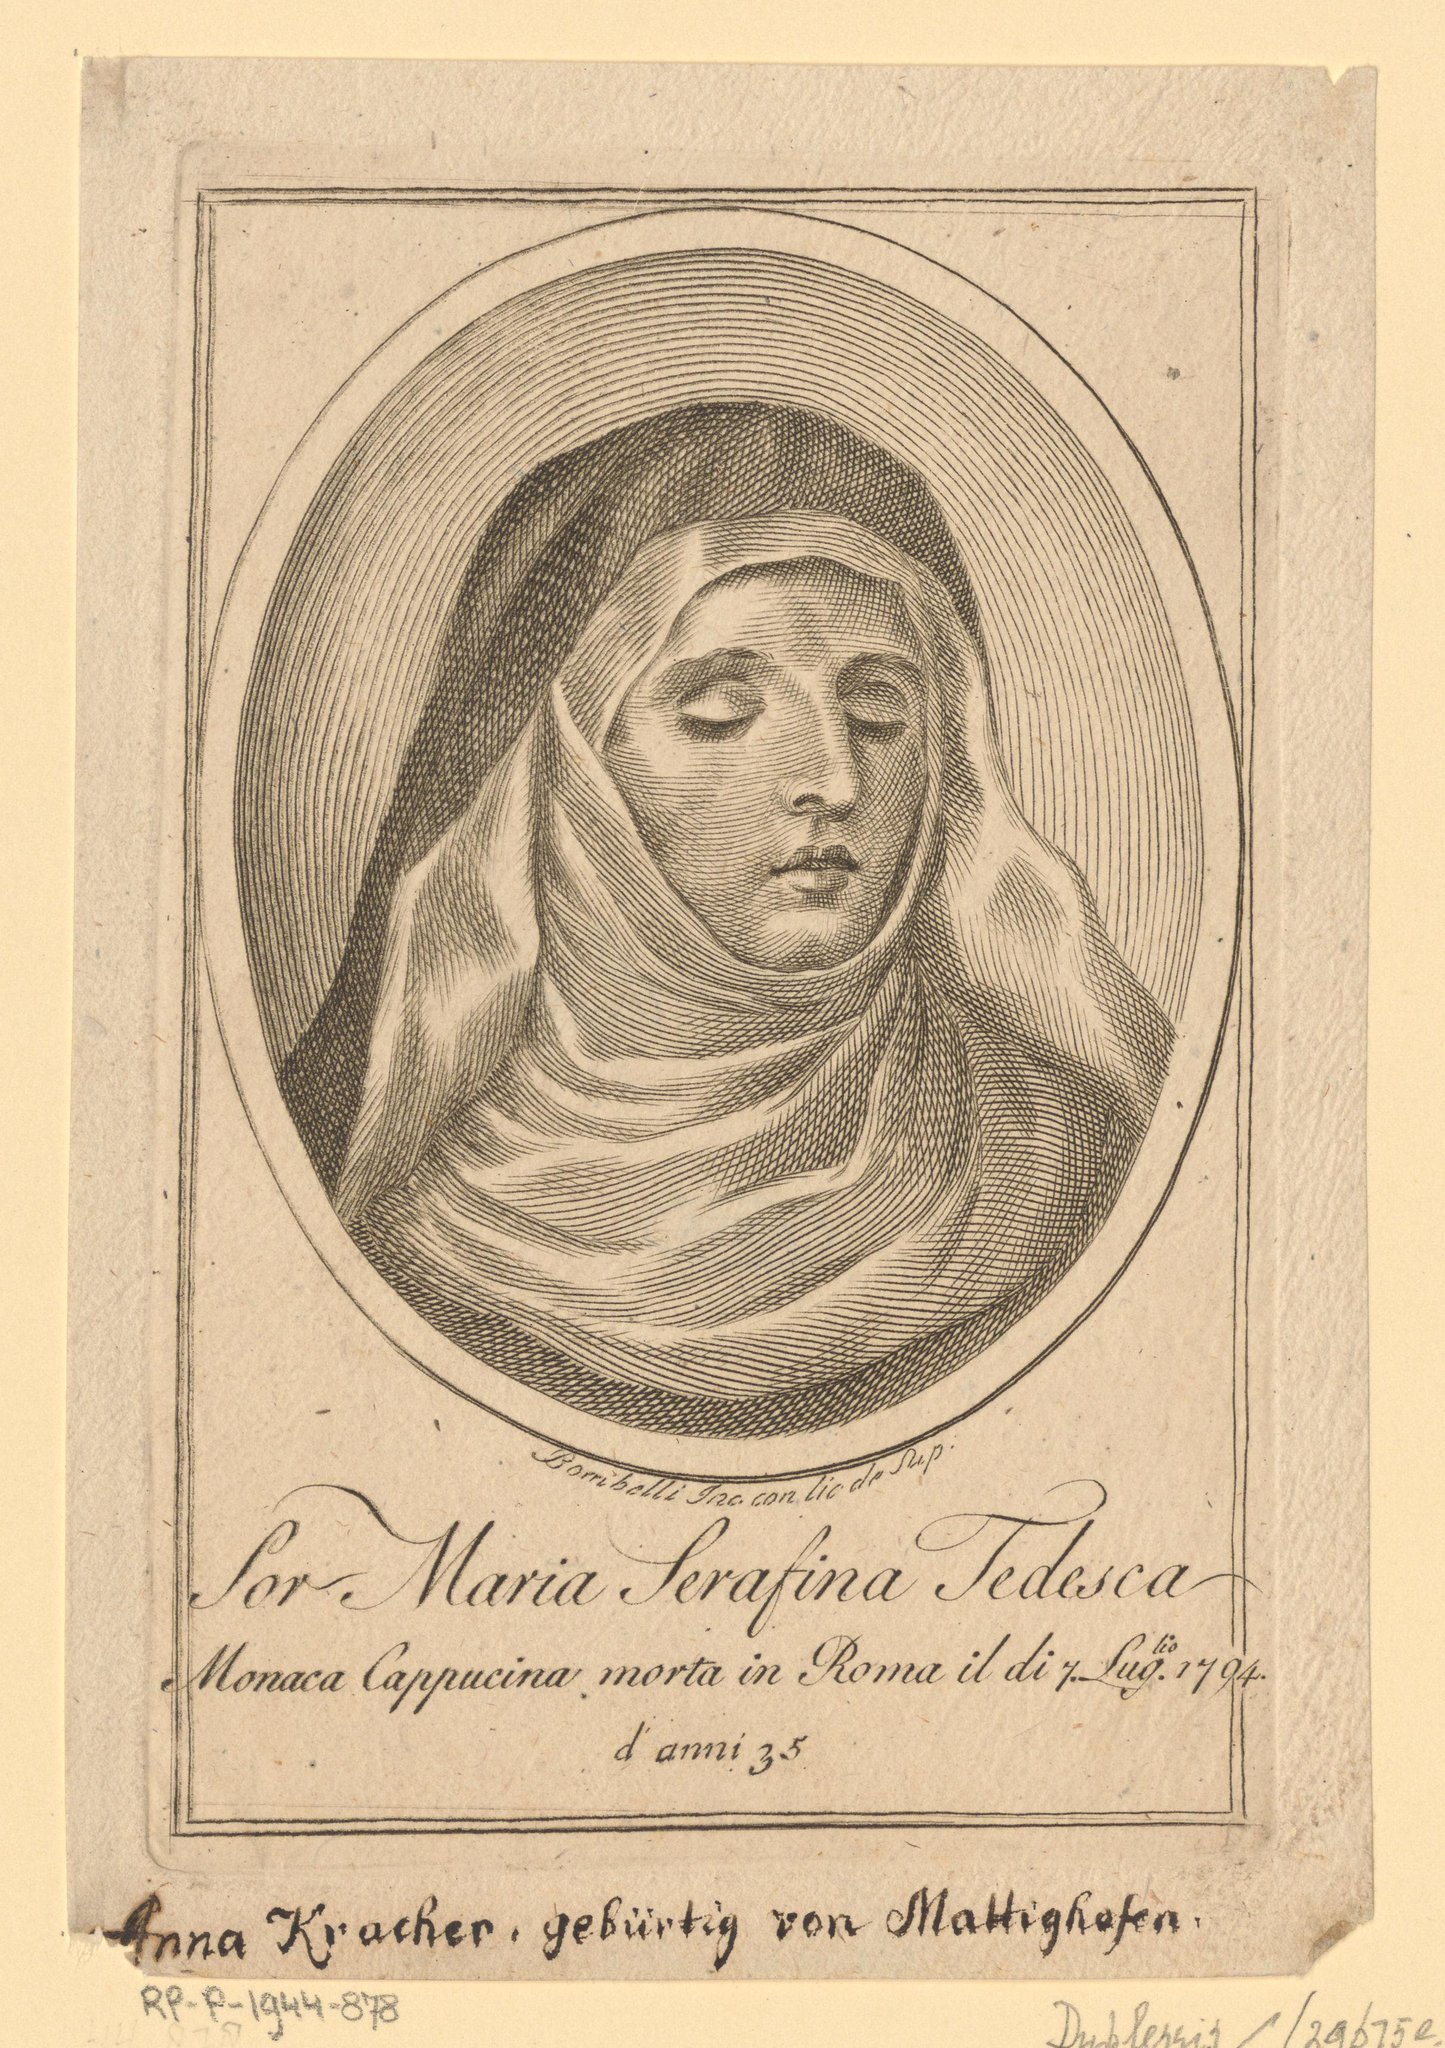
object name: print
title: Portret van Maria Serafina Tedesca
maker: Anonymous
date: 1794-1799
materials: paper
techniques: engraving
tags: rome, historical persons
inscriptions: collector's mark: Lugt 2228, signature: ‘Borribelli’